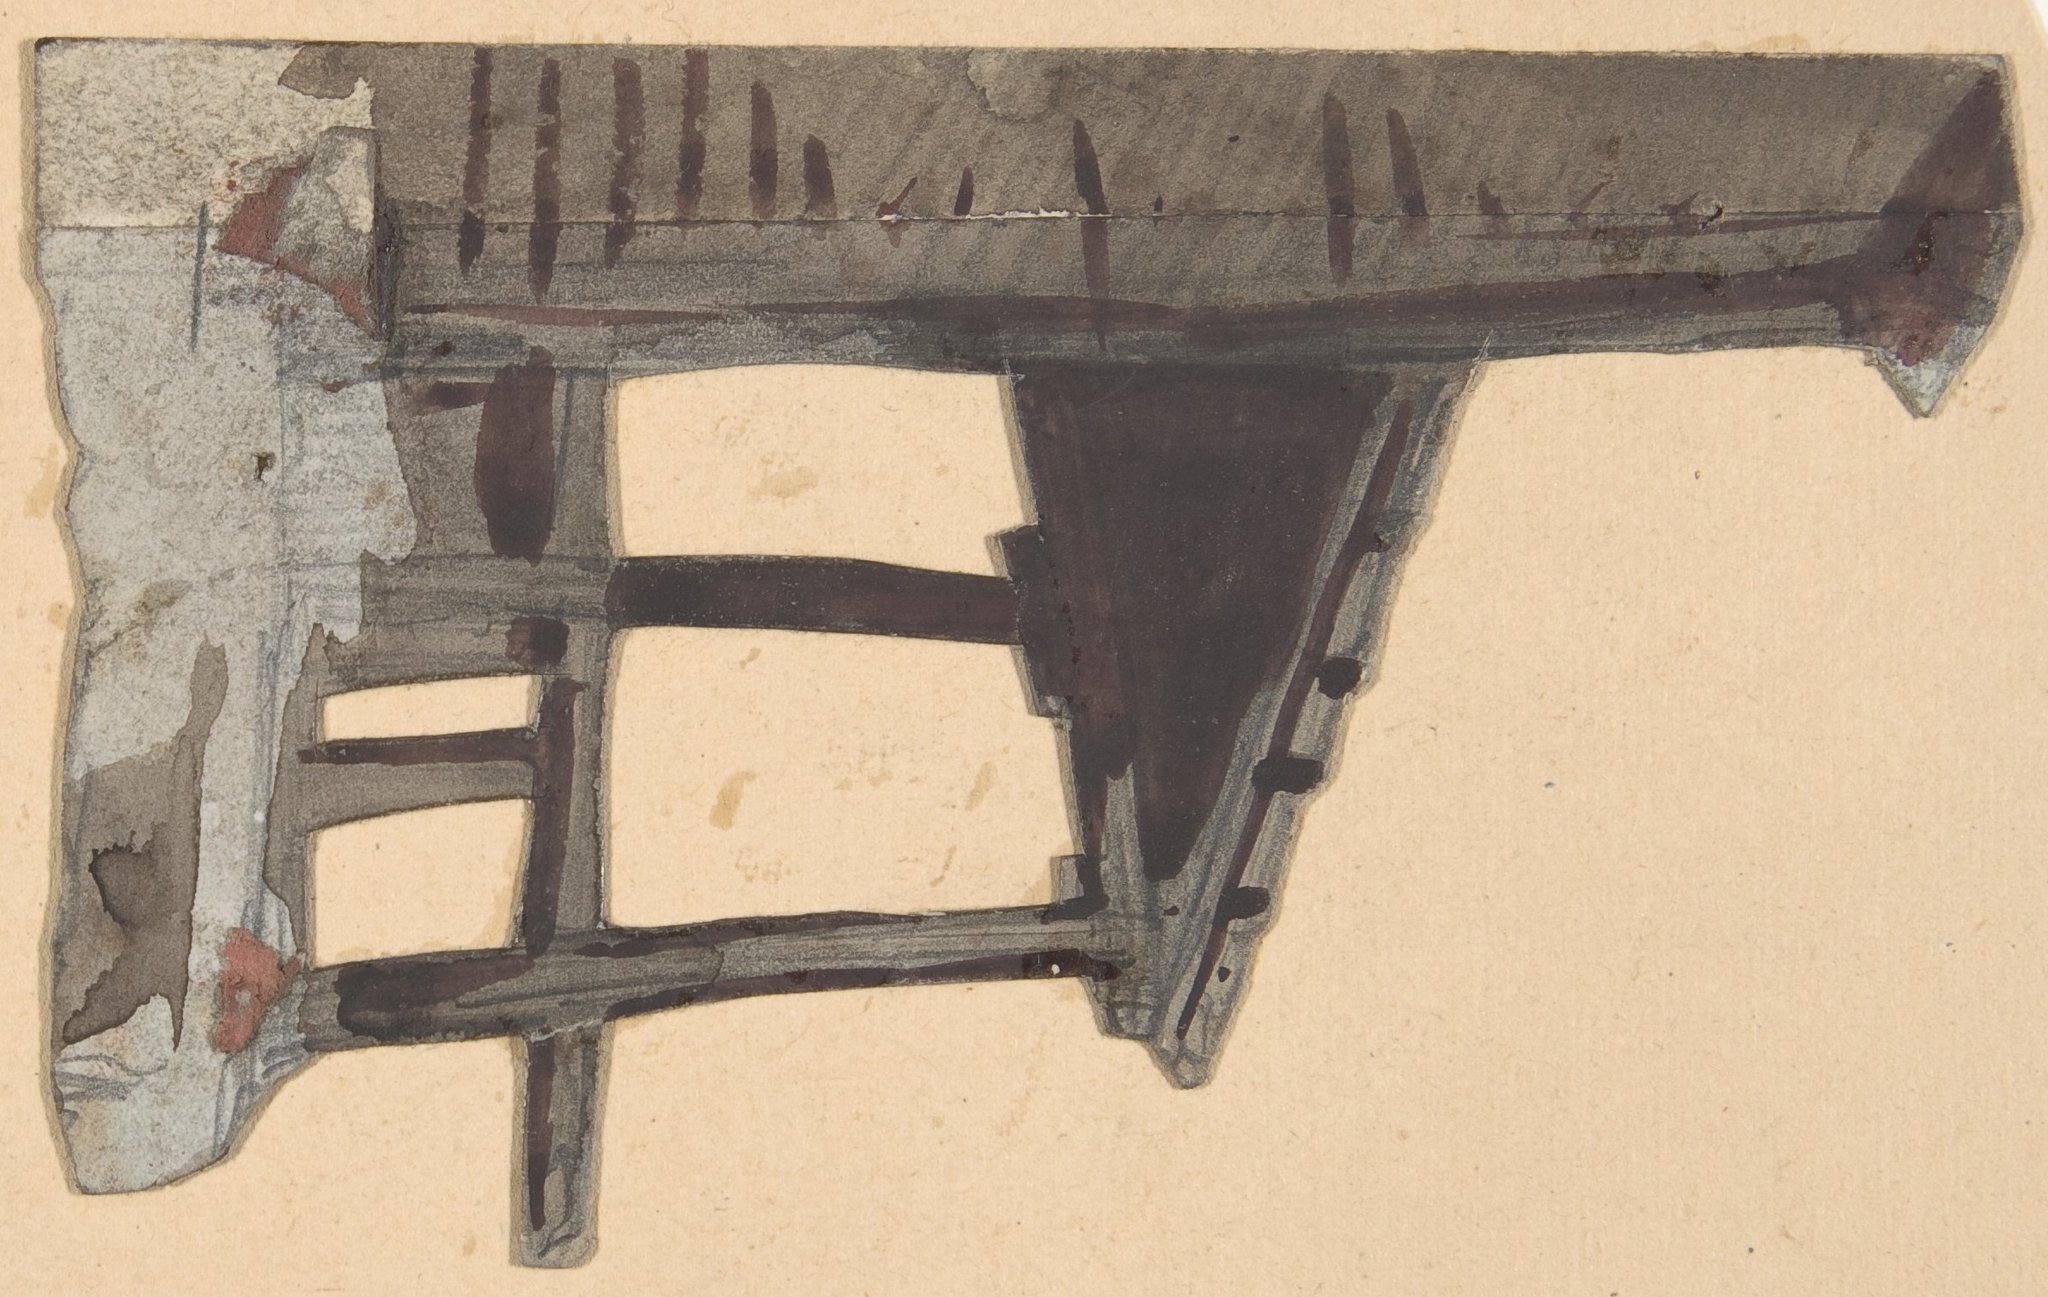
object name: drawing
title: Design for a Stage Set at the Opéra, Paris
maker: eugène cicéri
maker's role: artist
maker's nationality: french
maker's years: 1813-1890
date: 1830-1890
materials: graphite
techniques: brush, wash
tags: stage design